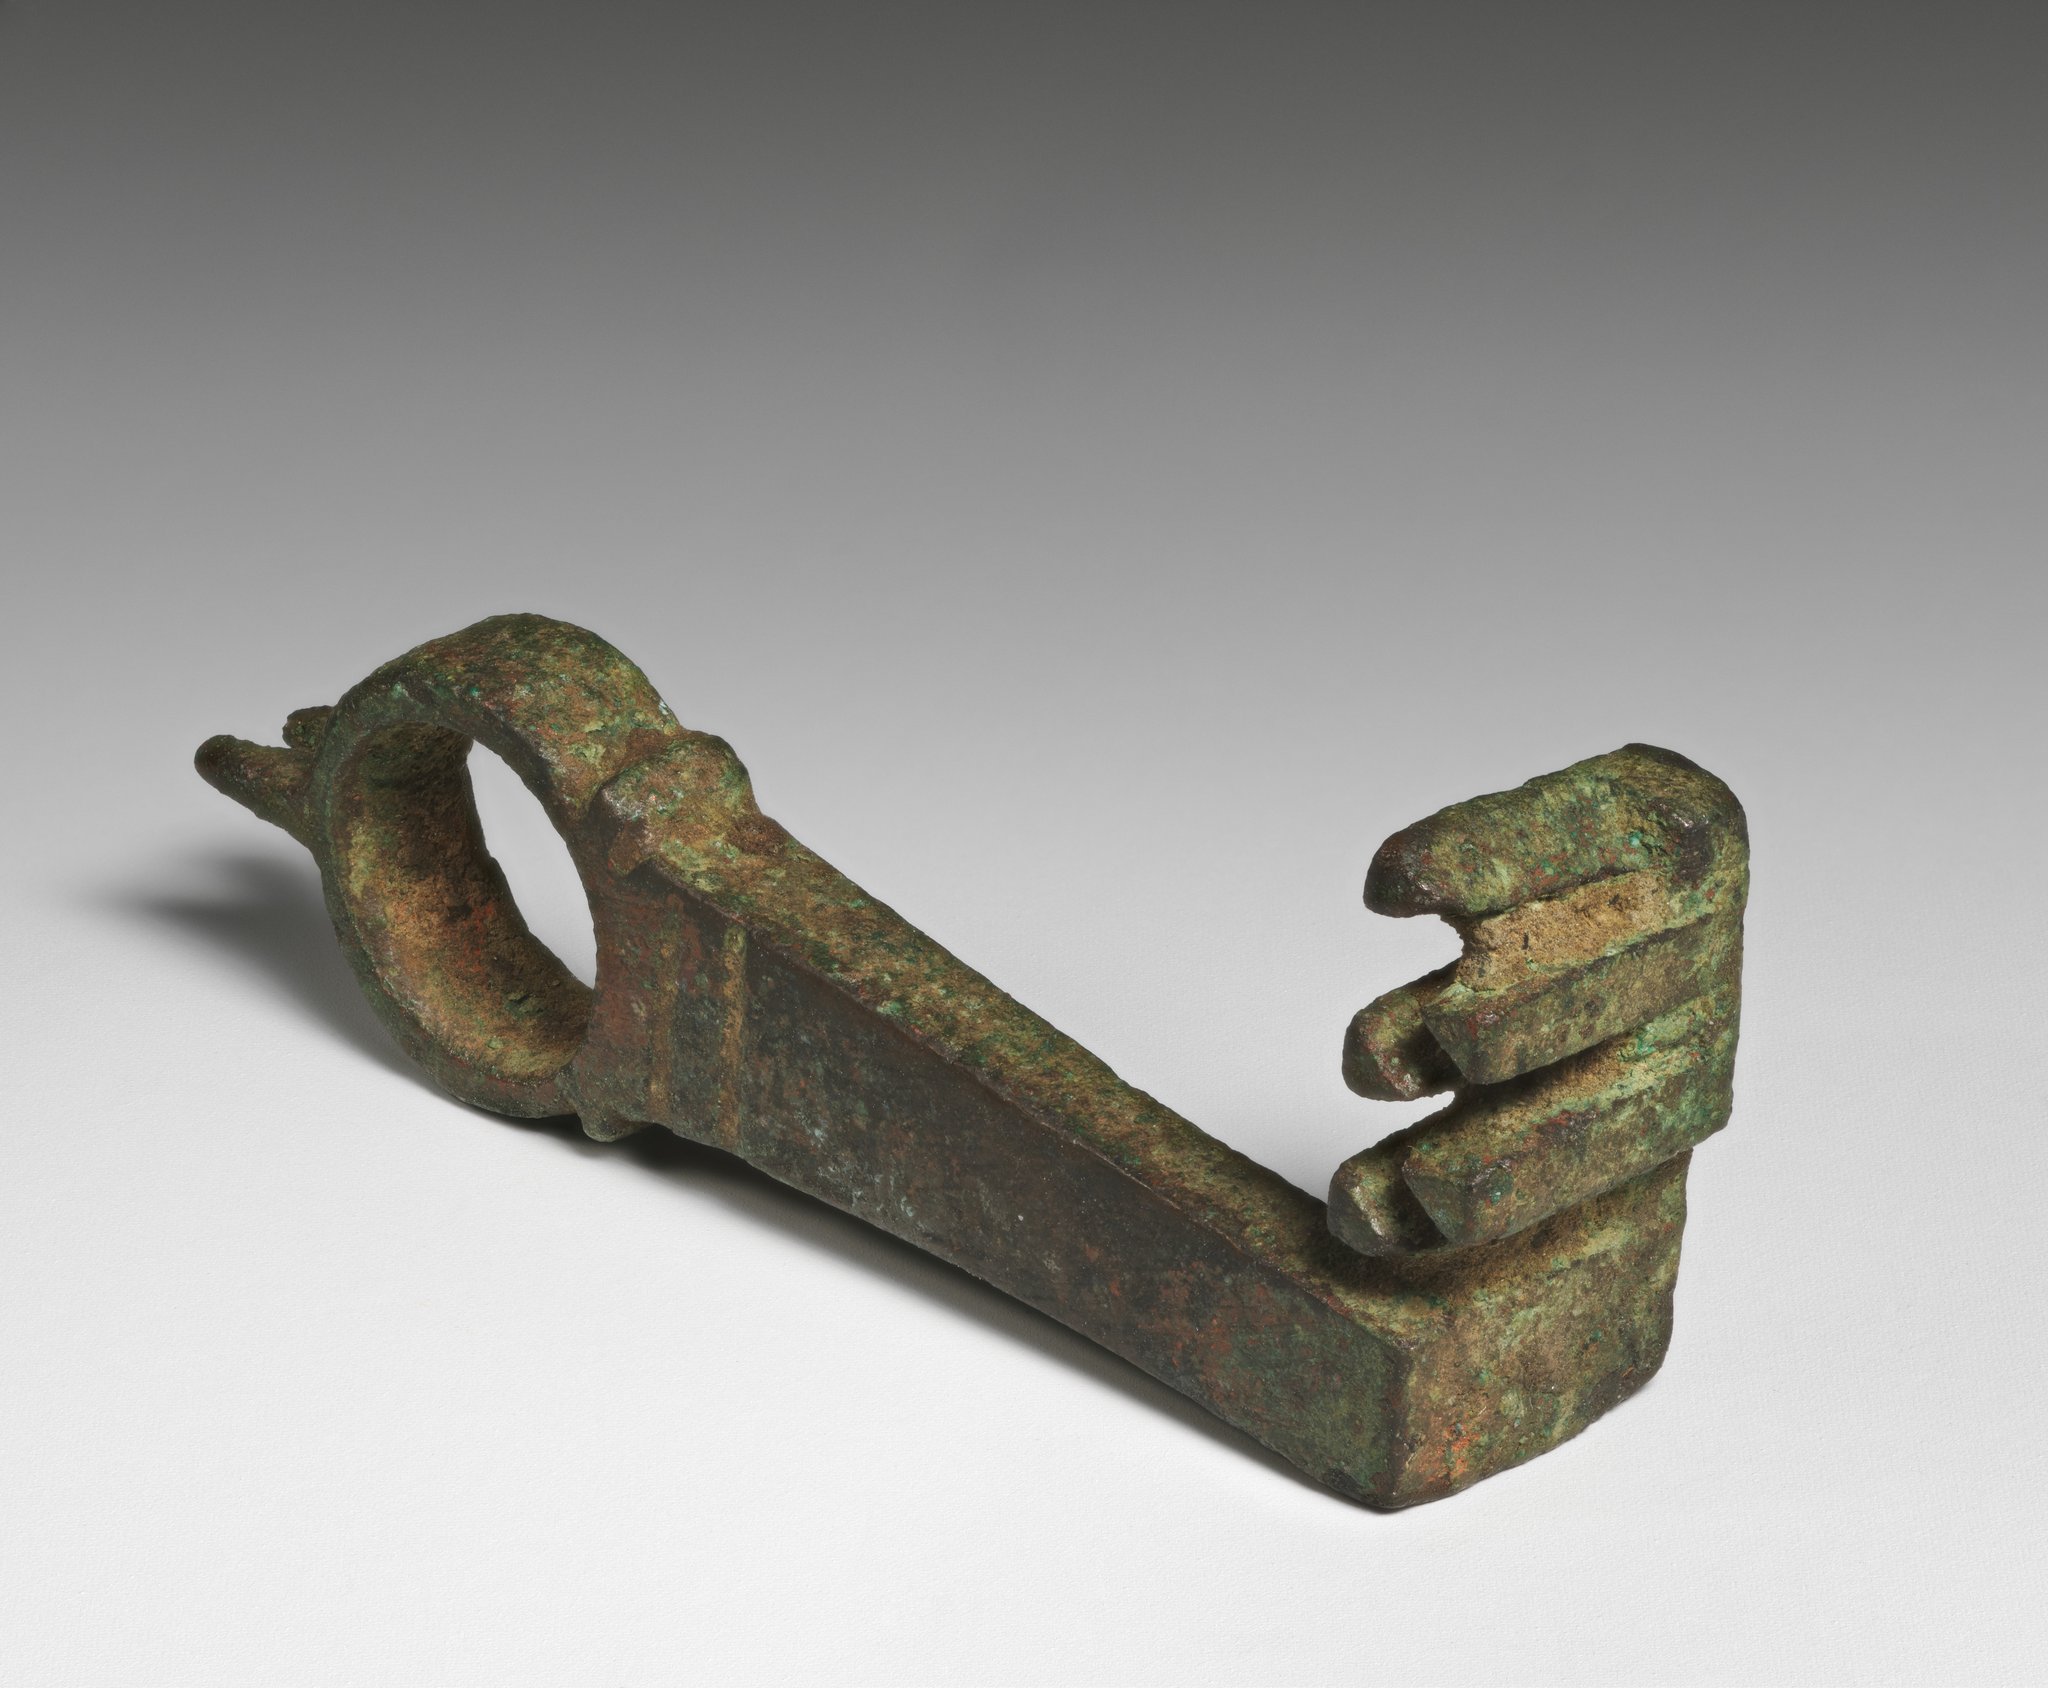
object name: key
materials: copper alloy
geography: egypt